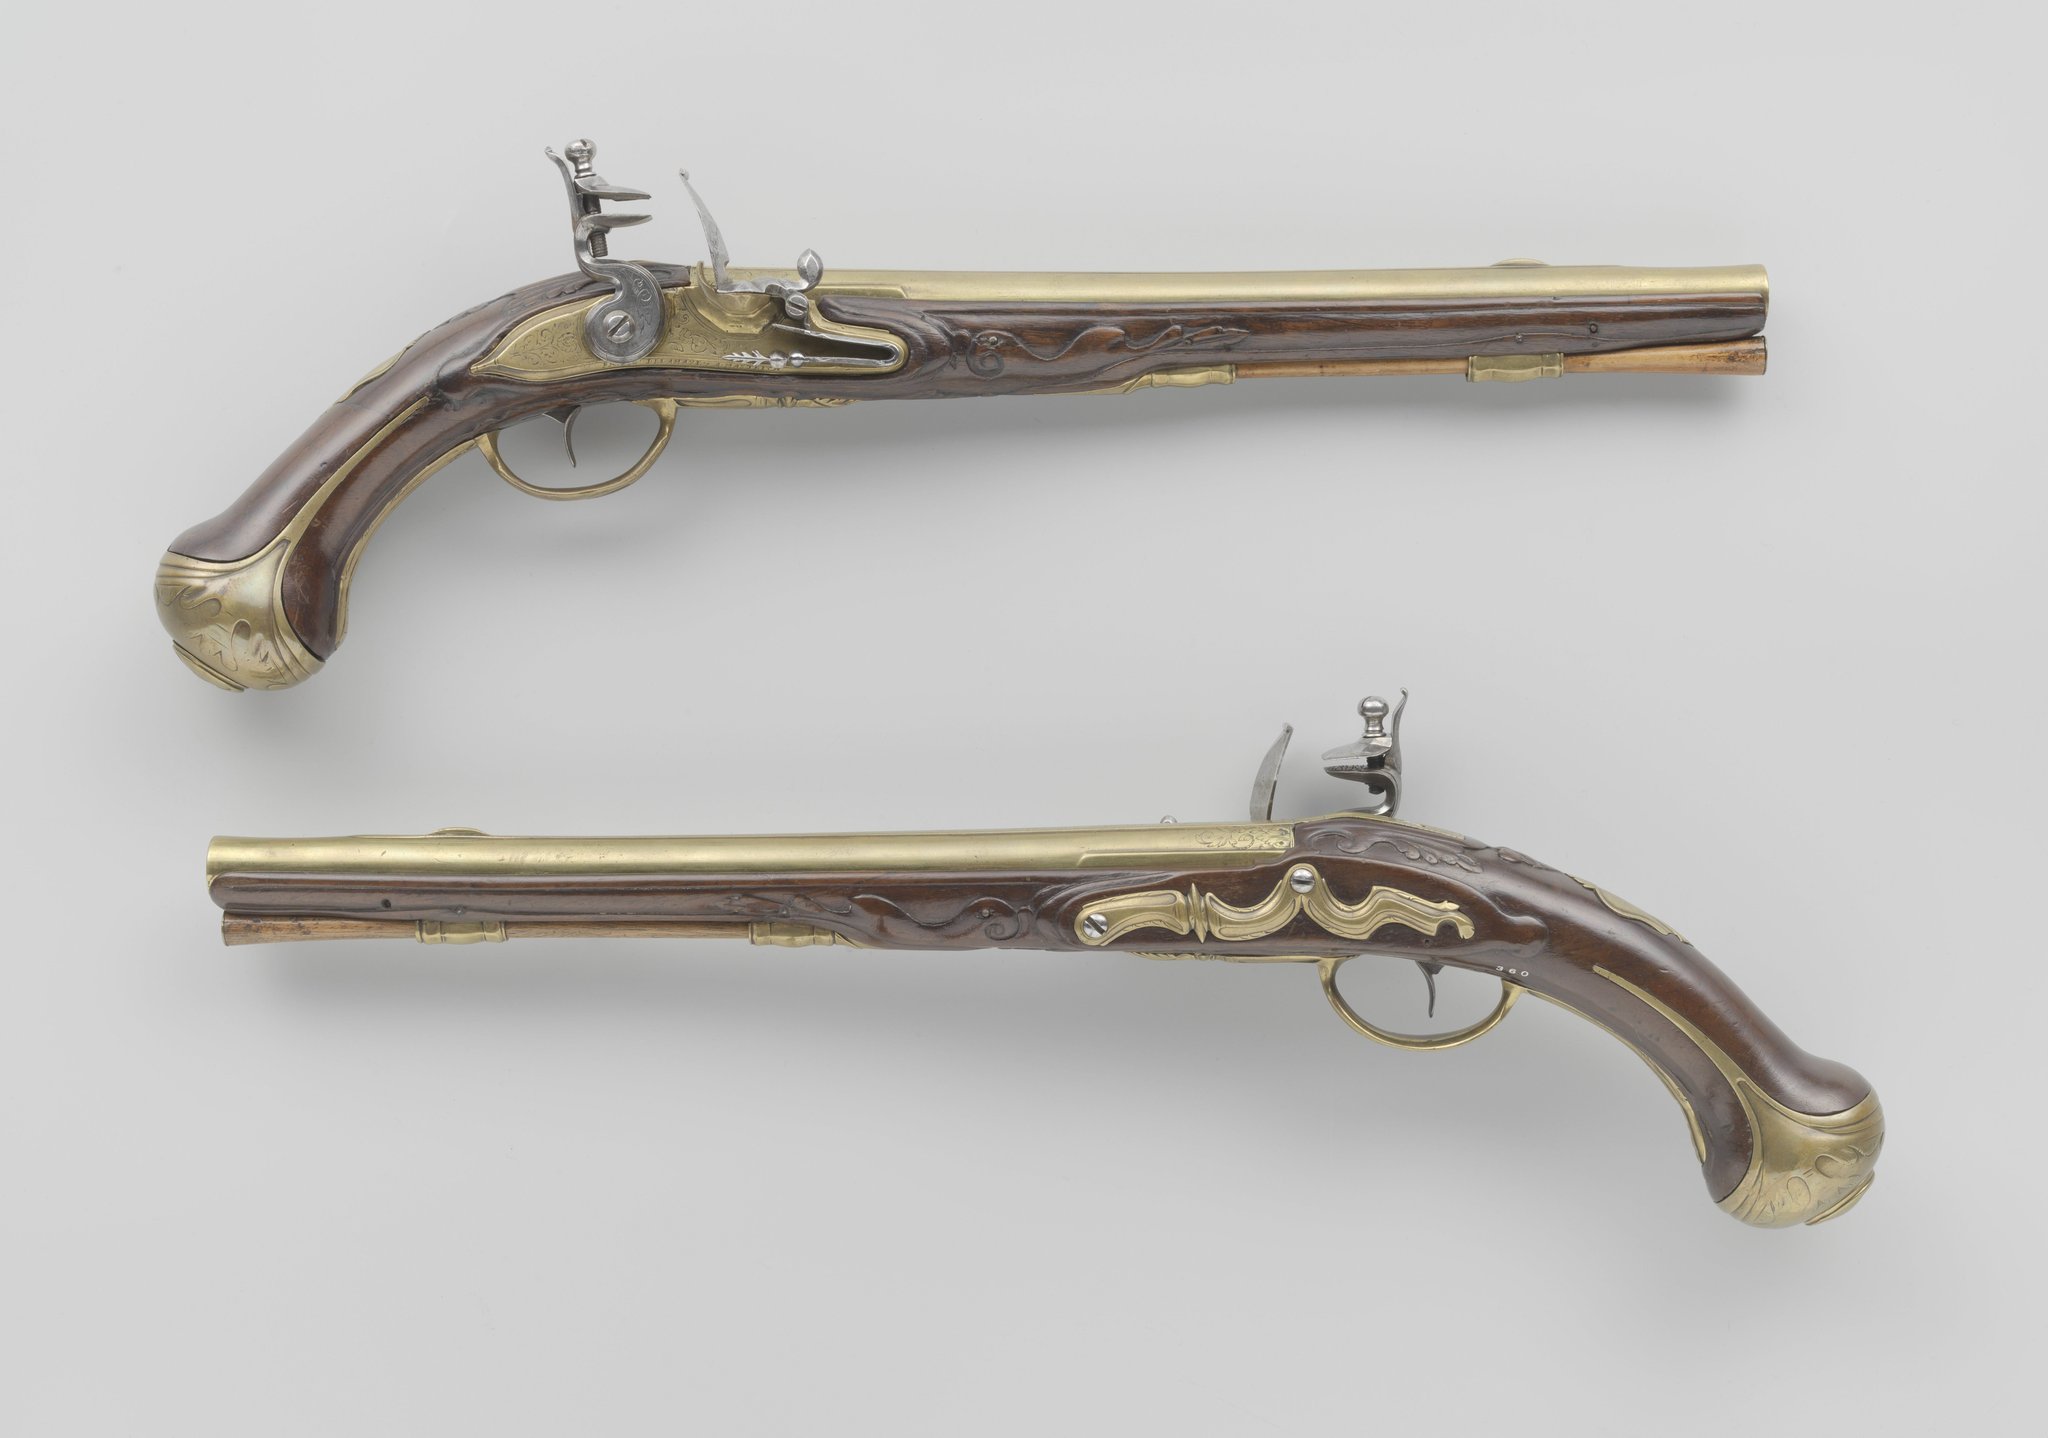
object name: flintlock pistol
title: Vuursteenpistool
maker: frans delahaye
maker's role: geweermaker, pistoolmaker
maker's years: 1673-1753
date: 1720-1730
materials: wood, brass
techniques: printing, cutting, engraving, gilding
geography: maastricht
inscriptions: inscription: ‘FRANS.DELAHAYE.A.MASTRICH’, : ‘I’